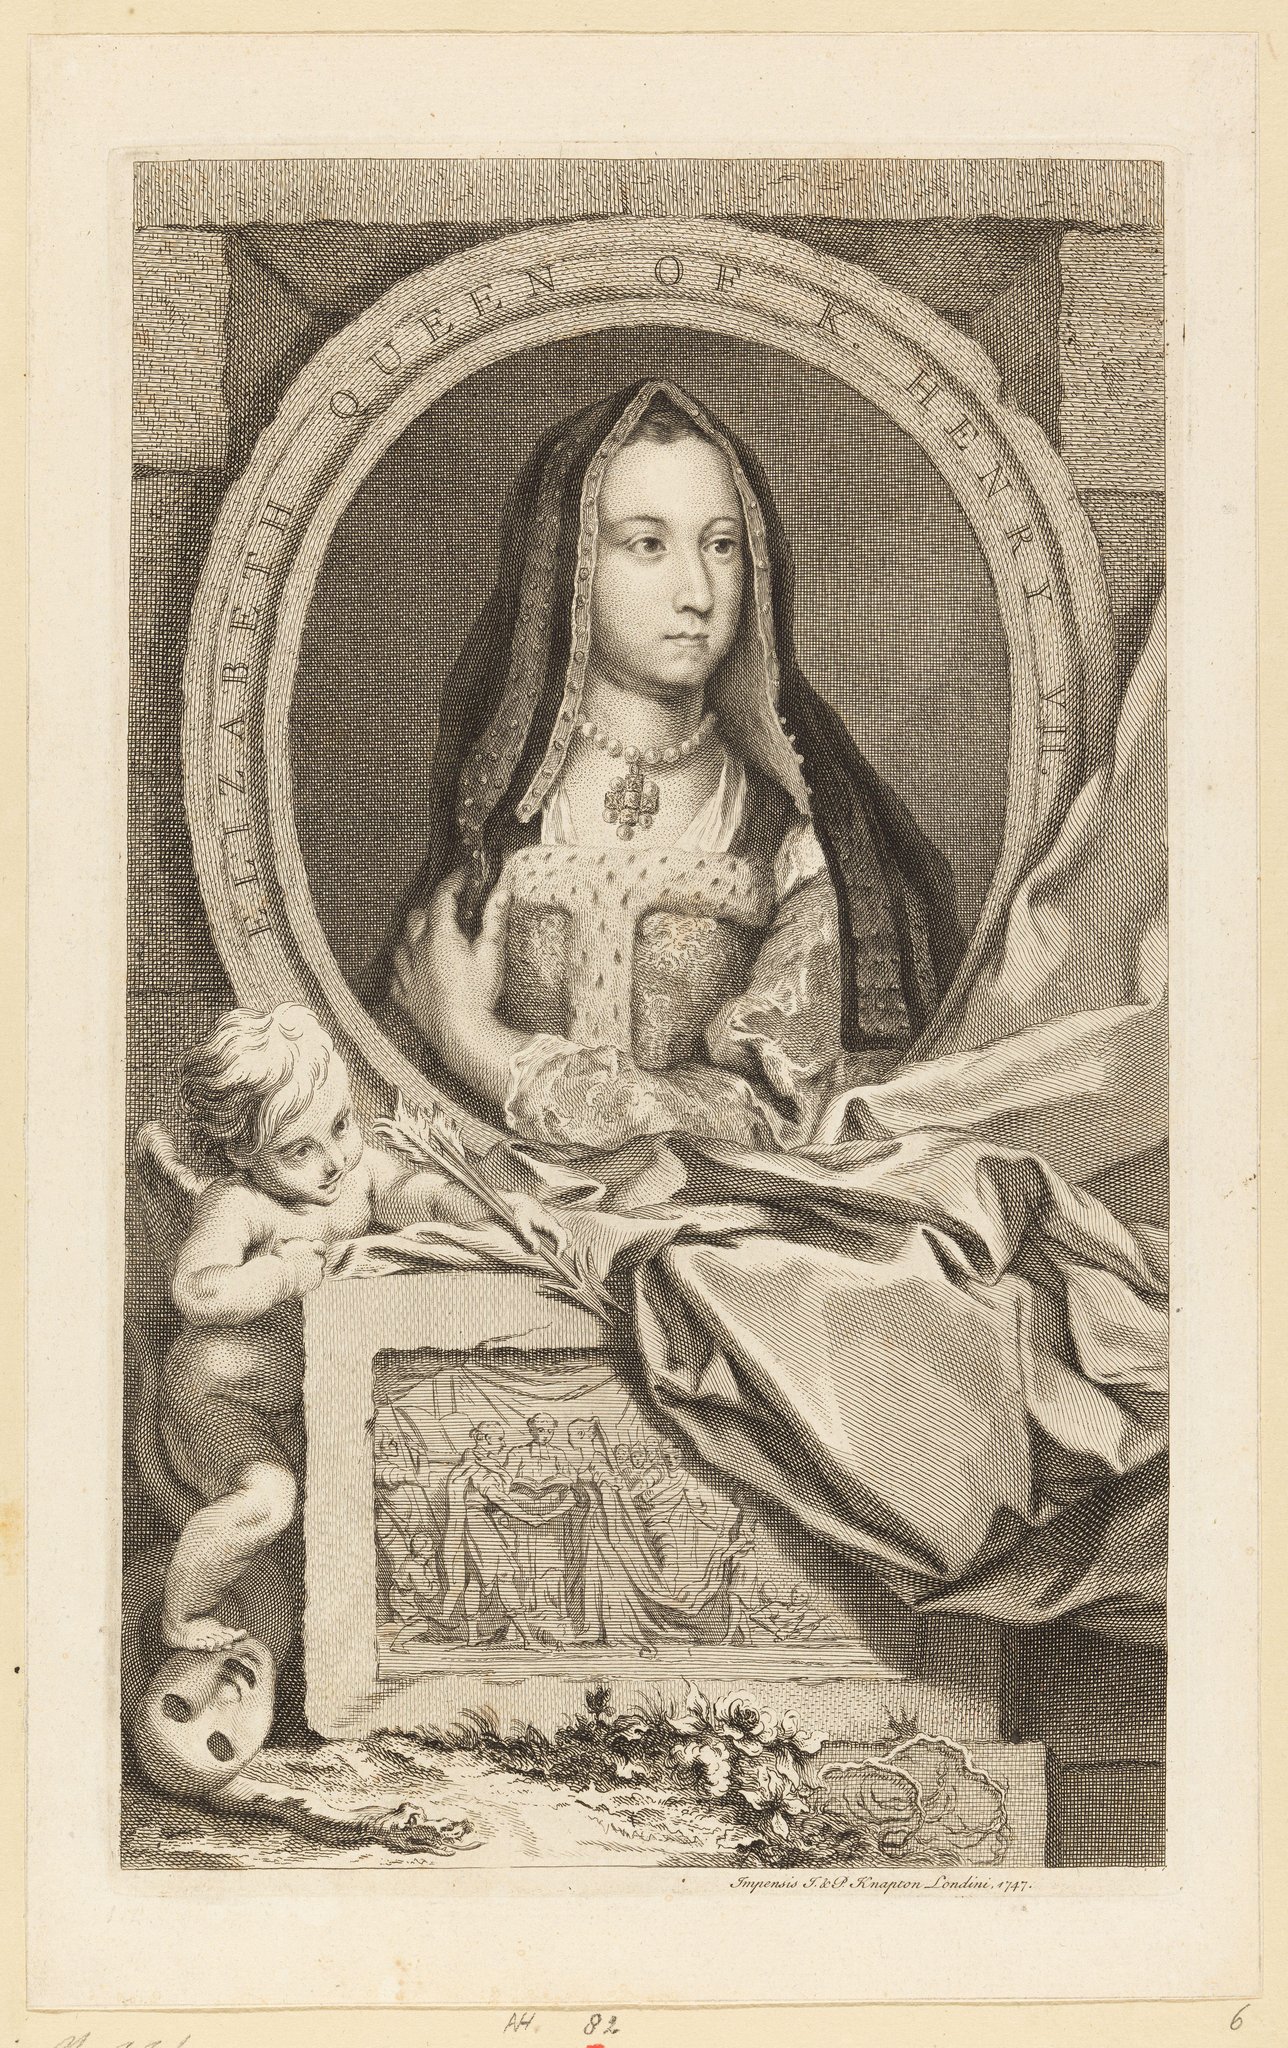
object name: print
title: Portret van Elizabeth van York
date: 1743-1747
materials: paper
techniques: engraving, etching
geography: london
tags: historical persons, queen, (civil) marriage ceremonies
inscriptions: collector's mark: Lugt 240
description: Prent gebruikt in: Birch, Thomas. The heads of illustrious persons of Great Britain (...). Londen: John & Paul Knapton, 1747.